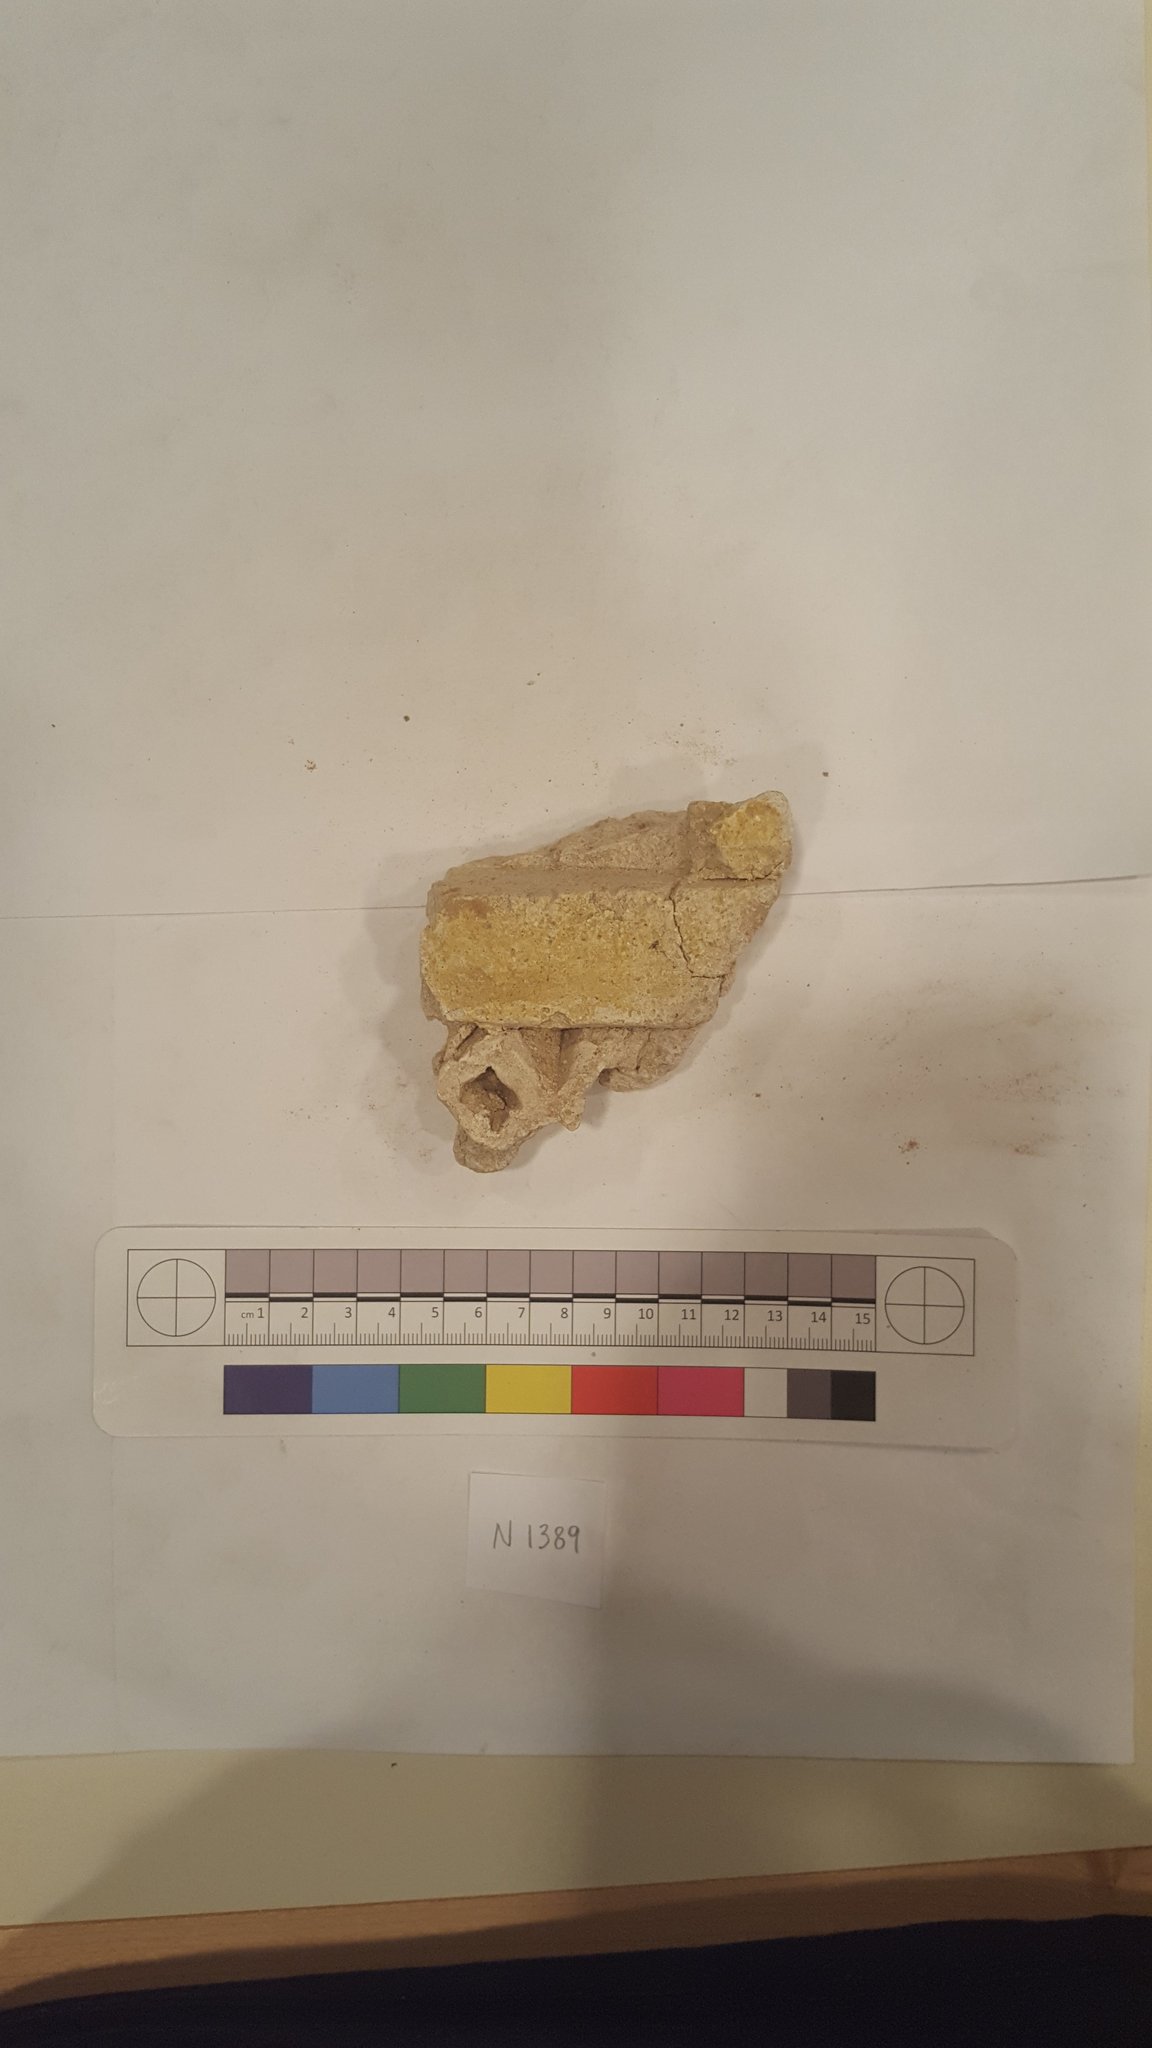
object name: fragment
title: Stucco Fragment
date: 701-1200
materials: plaster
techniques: carving, painting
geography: iran